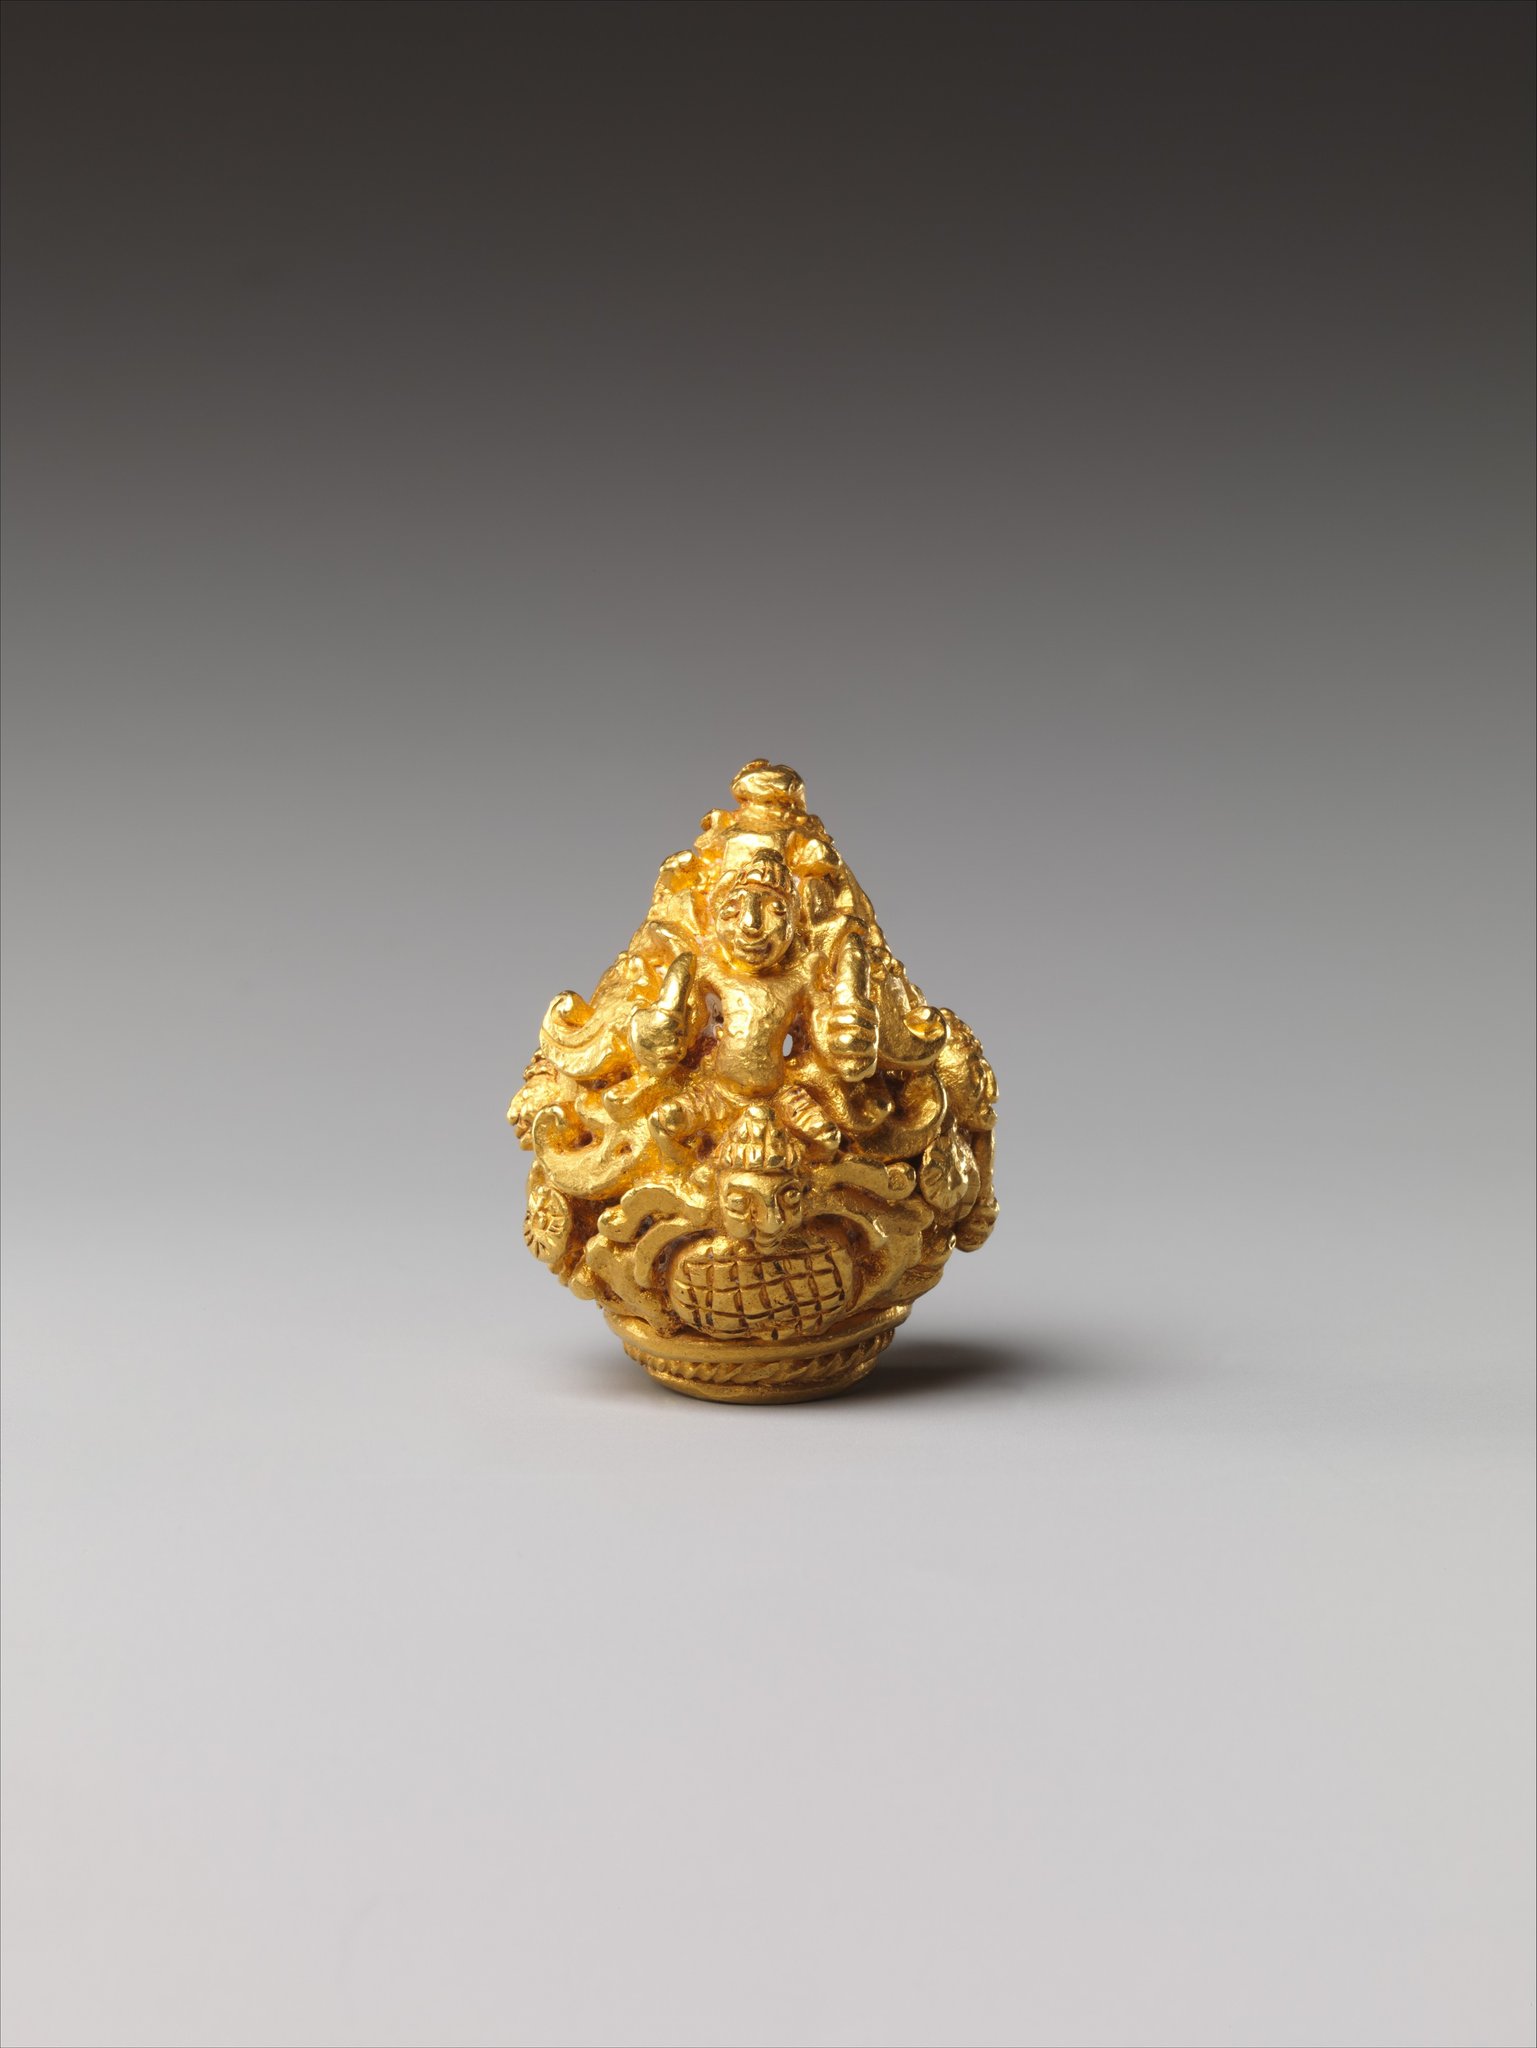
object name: ear ornament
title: Ear Ornament in the form of Vishnu Riding Garuda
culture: indonesian, javanese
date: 867-933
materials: gold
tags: vishnu